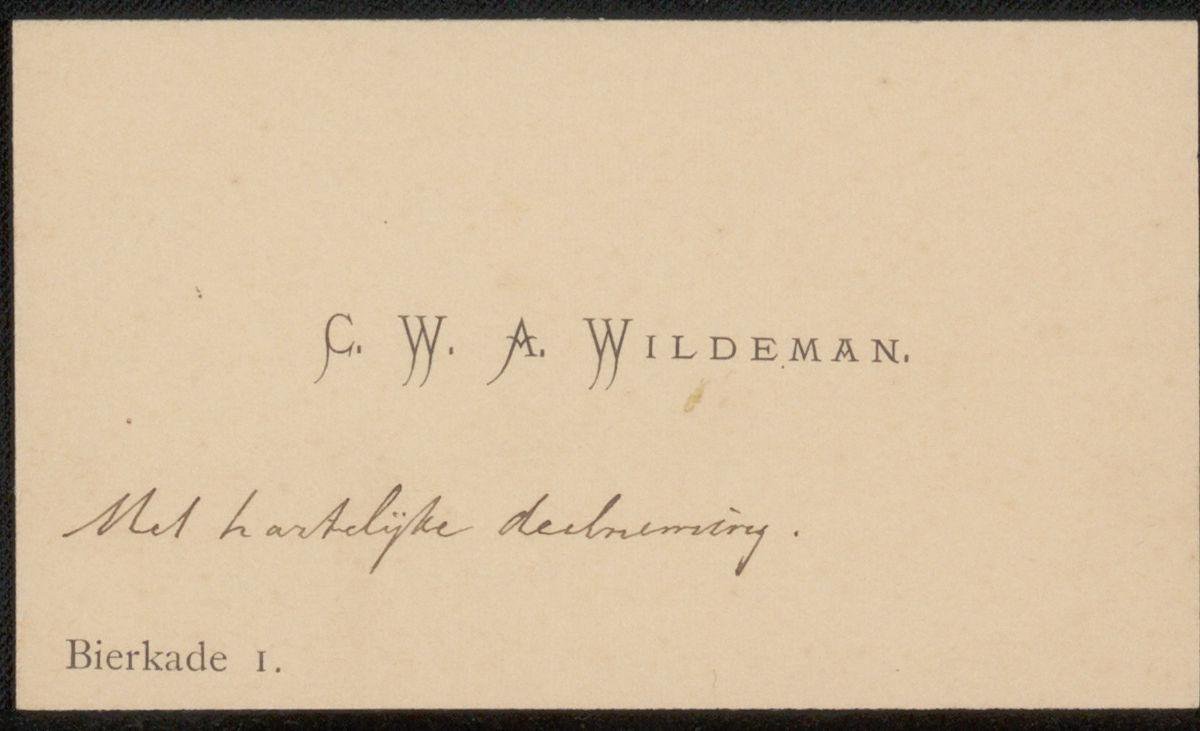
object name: visiting card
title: Visitekaartje aan Philip Zilcken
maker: c.w.a. wildeman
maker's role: majoor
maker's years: 1818-1903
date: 1867-1903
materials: cardboard, ink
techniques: pen, printing, writing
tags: painter, draughtsman, philip zilcken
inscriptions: collector's mark: ‘RPK’